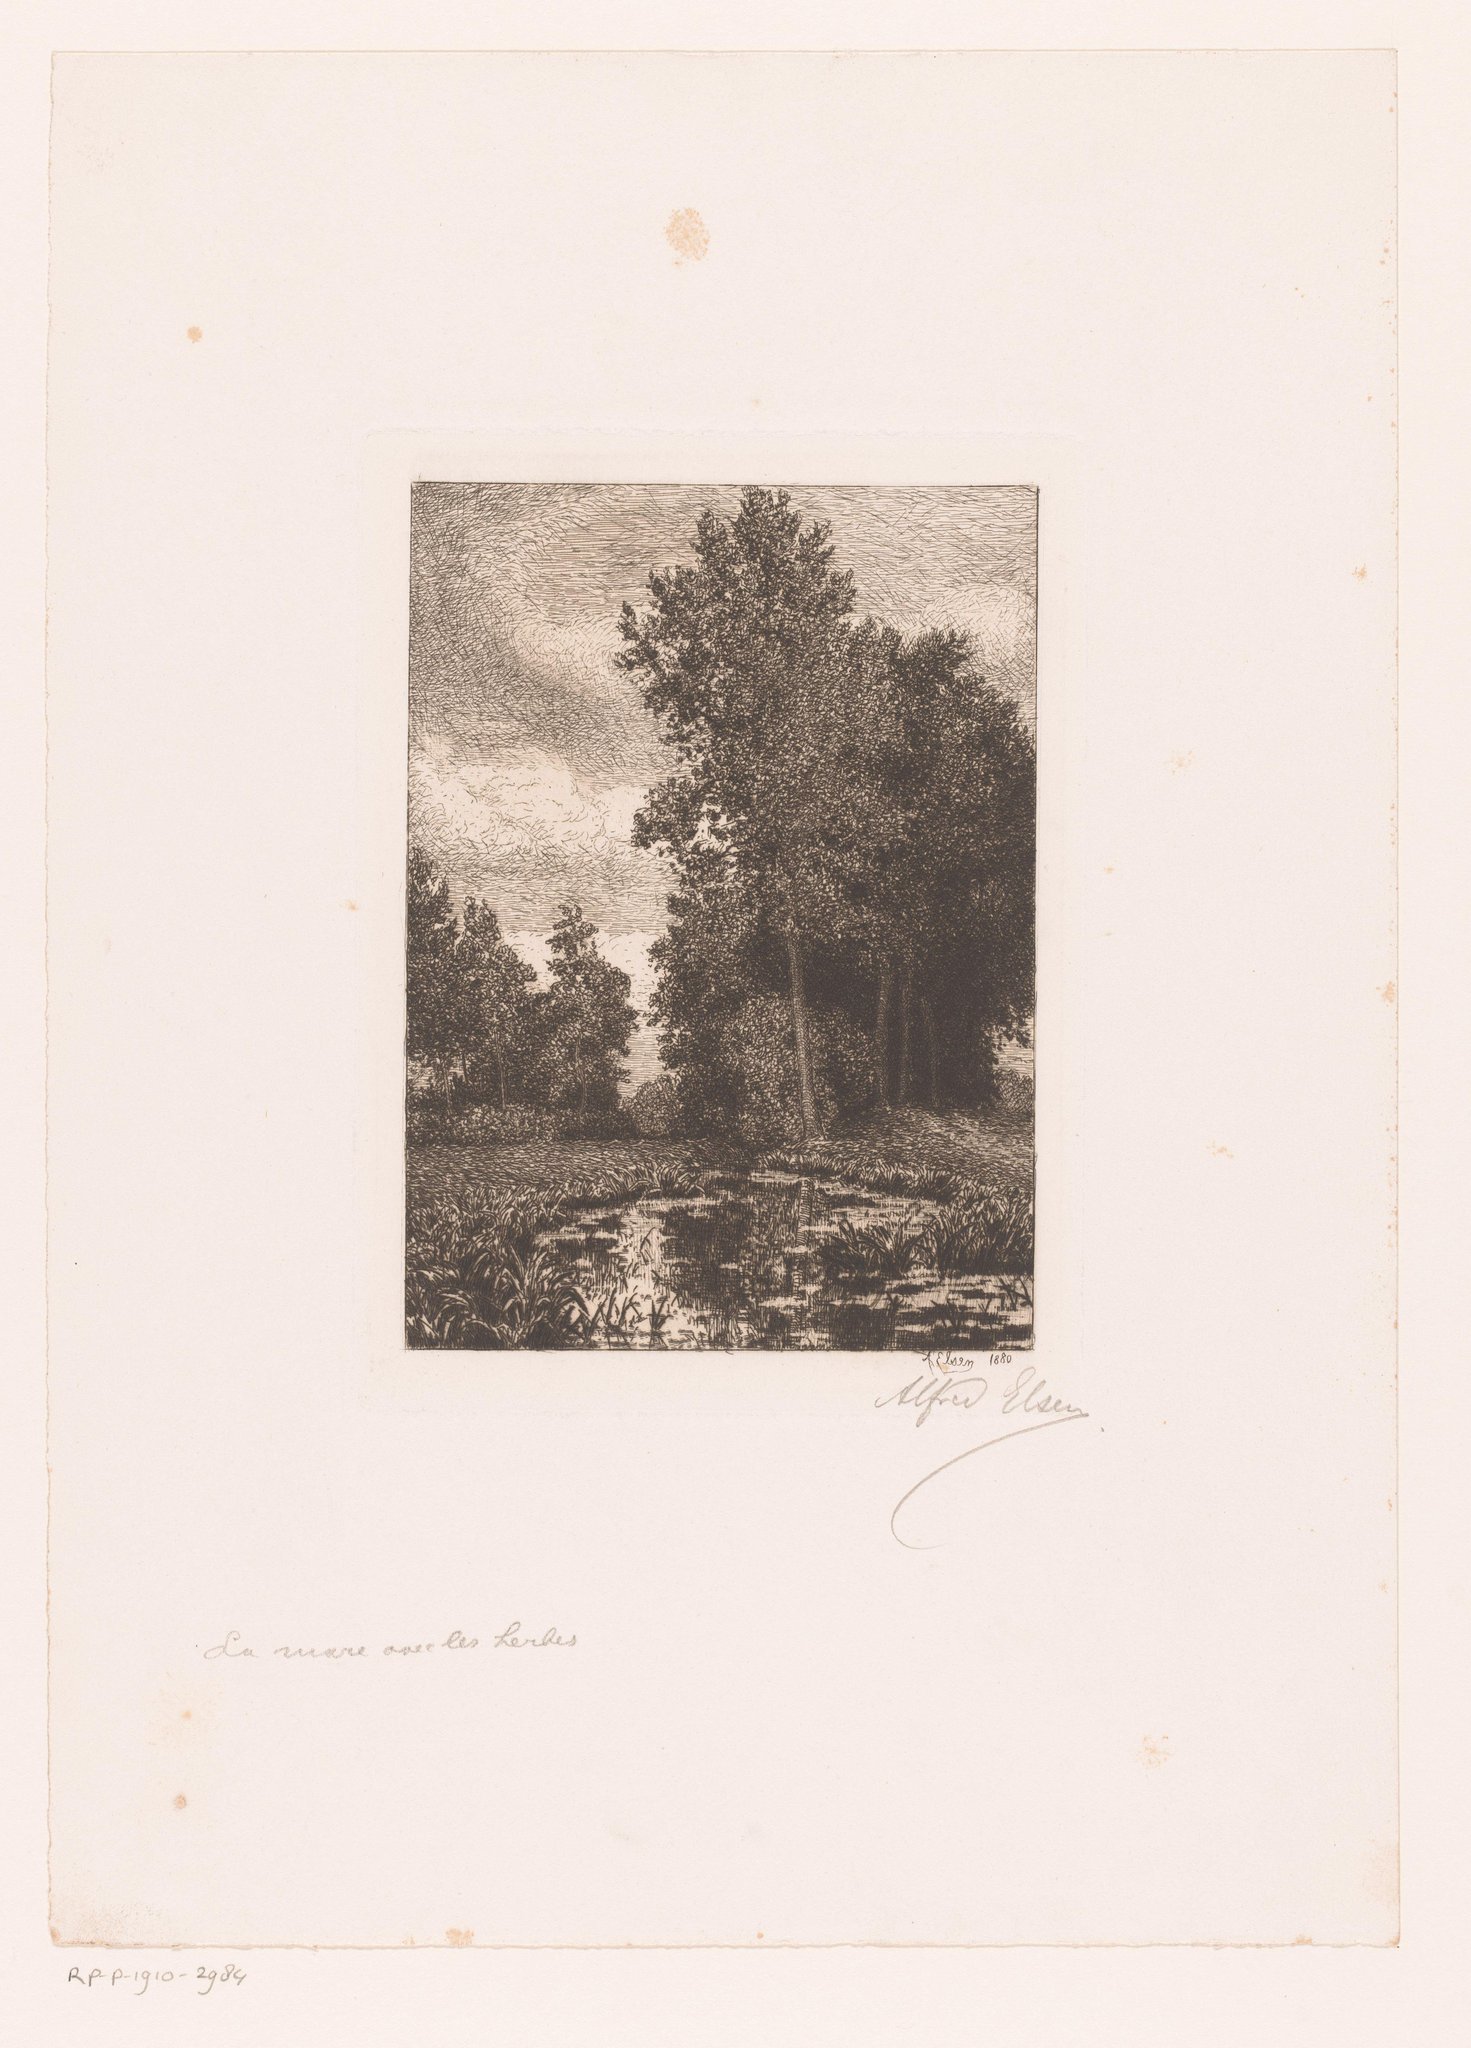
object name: print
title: Landschap met beek op de voorgrond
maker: alfred elsen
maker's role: painter, print maker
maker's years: 1850-1914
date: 1880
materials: paper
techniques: etching, intaglio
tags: brook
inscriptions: collector's mark: Lugt 2228